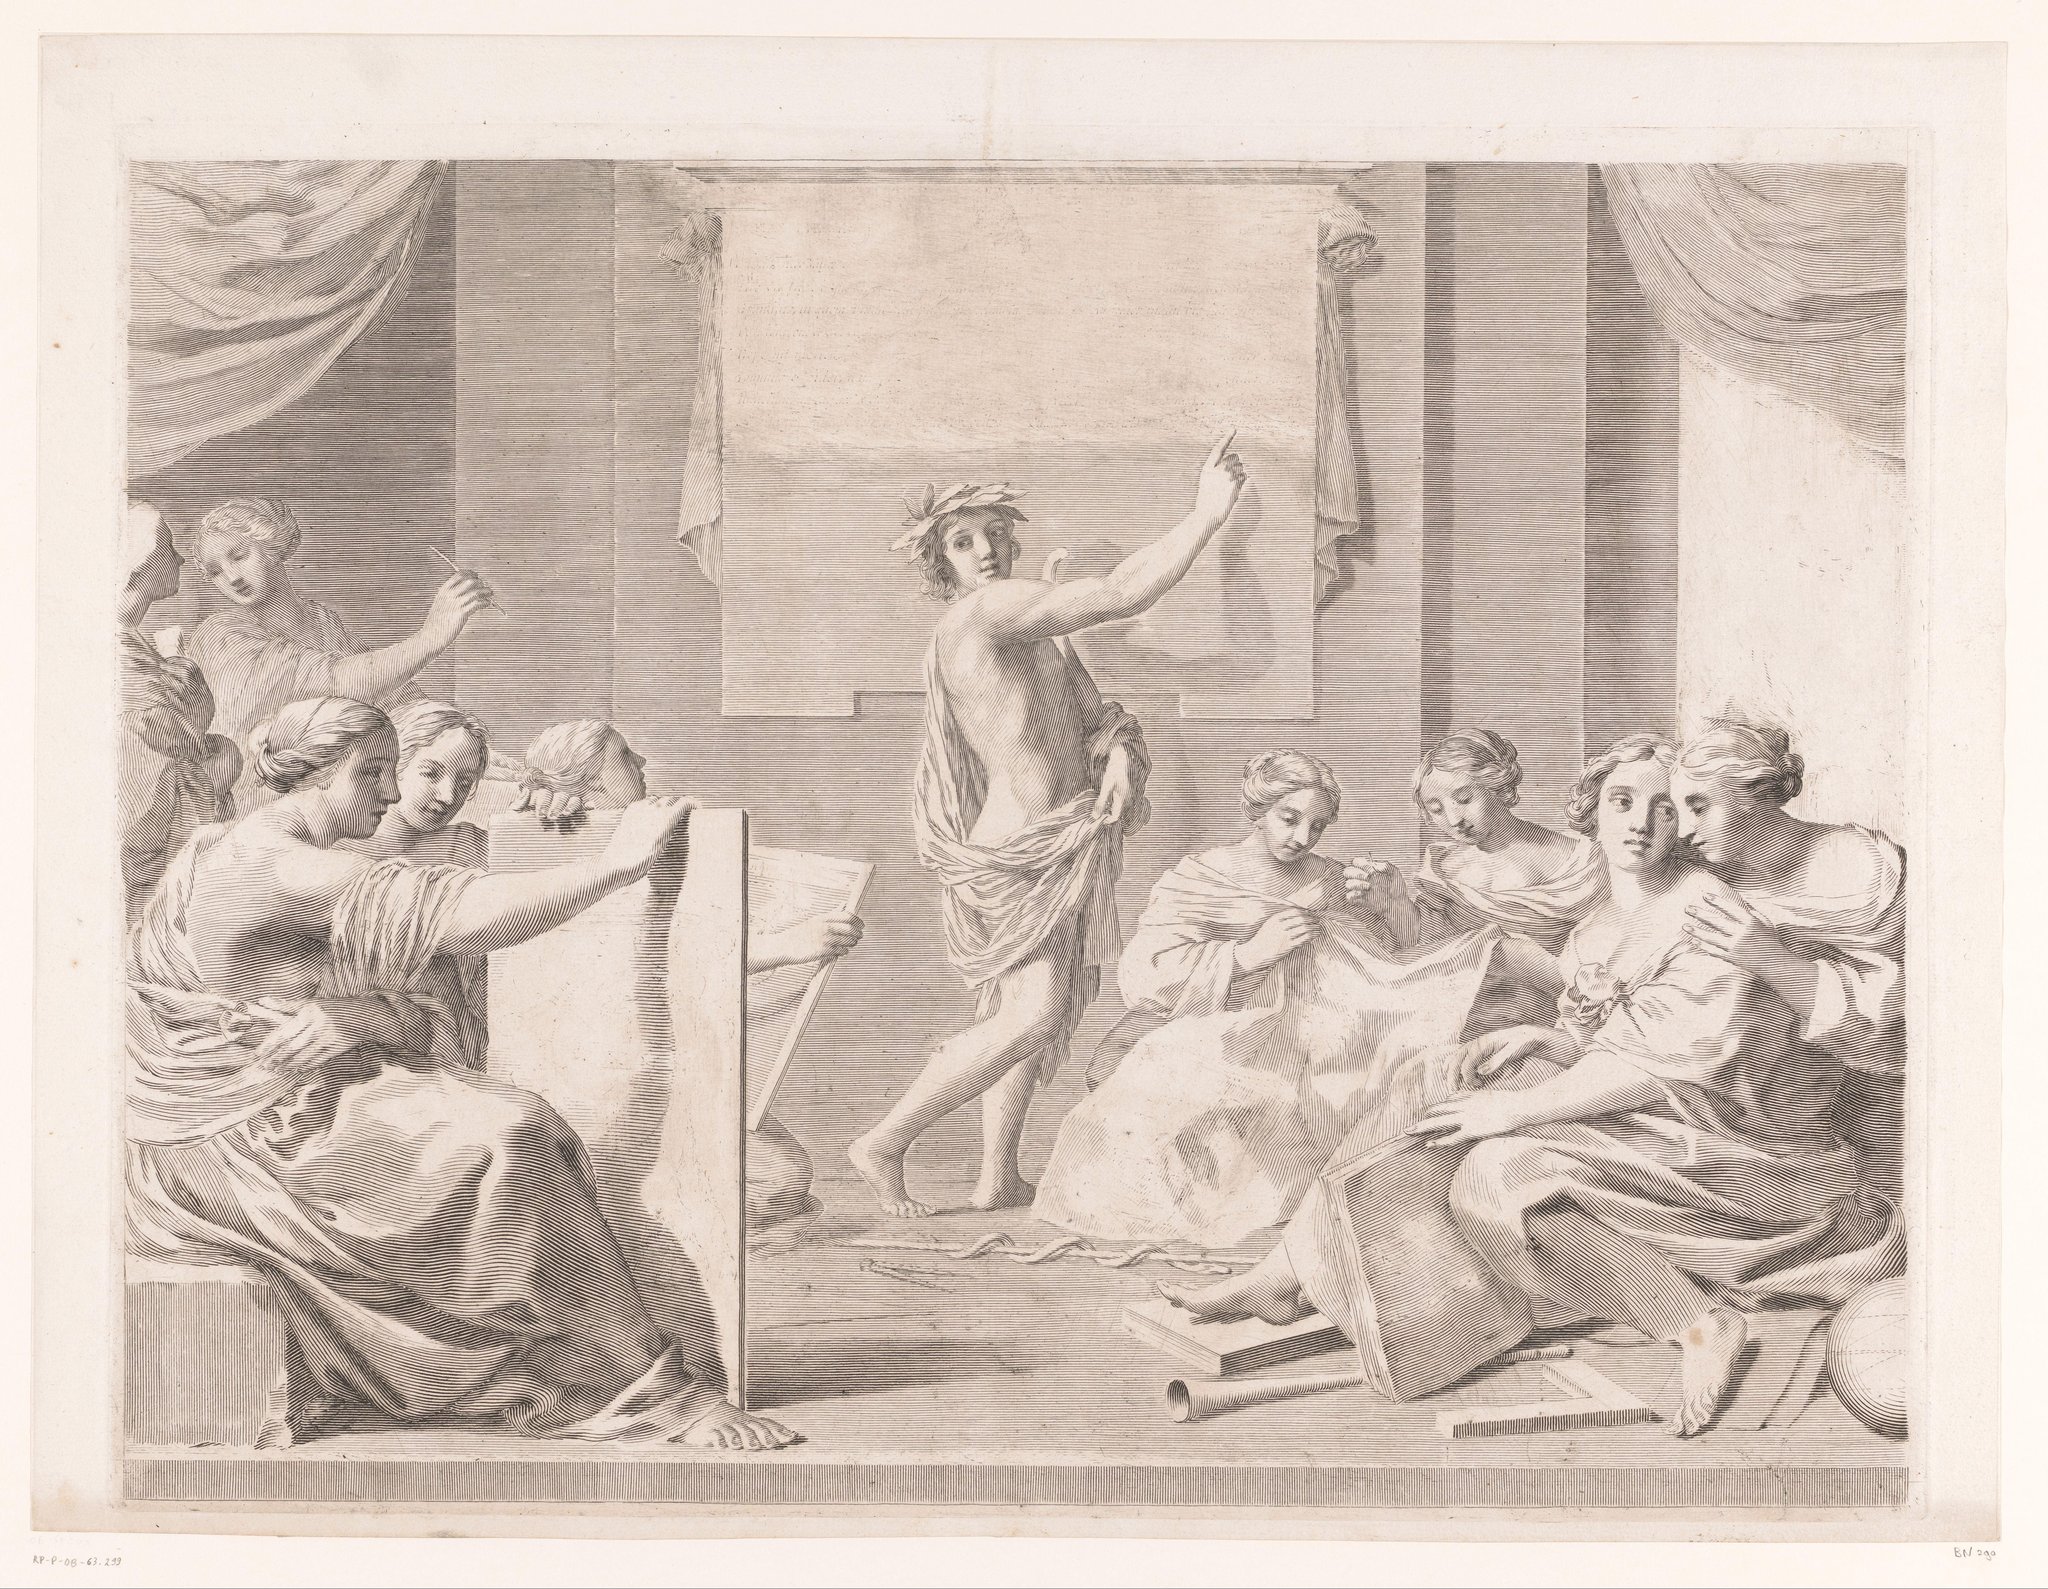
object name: print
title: These over filosofie van Guillaume de Longueil (bovendeel)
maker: claude mellan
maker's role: draughtsman, print maker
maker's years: 1598-1688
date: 1646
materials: paper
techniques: engraving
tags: apollo and the muses, apollo musagetes, philosophy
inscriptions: collector's mark: Lugt 240